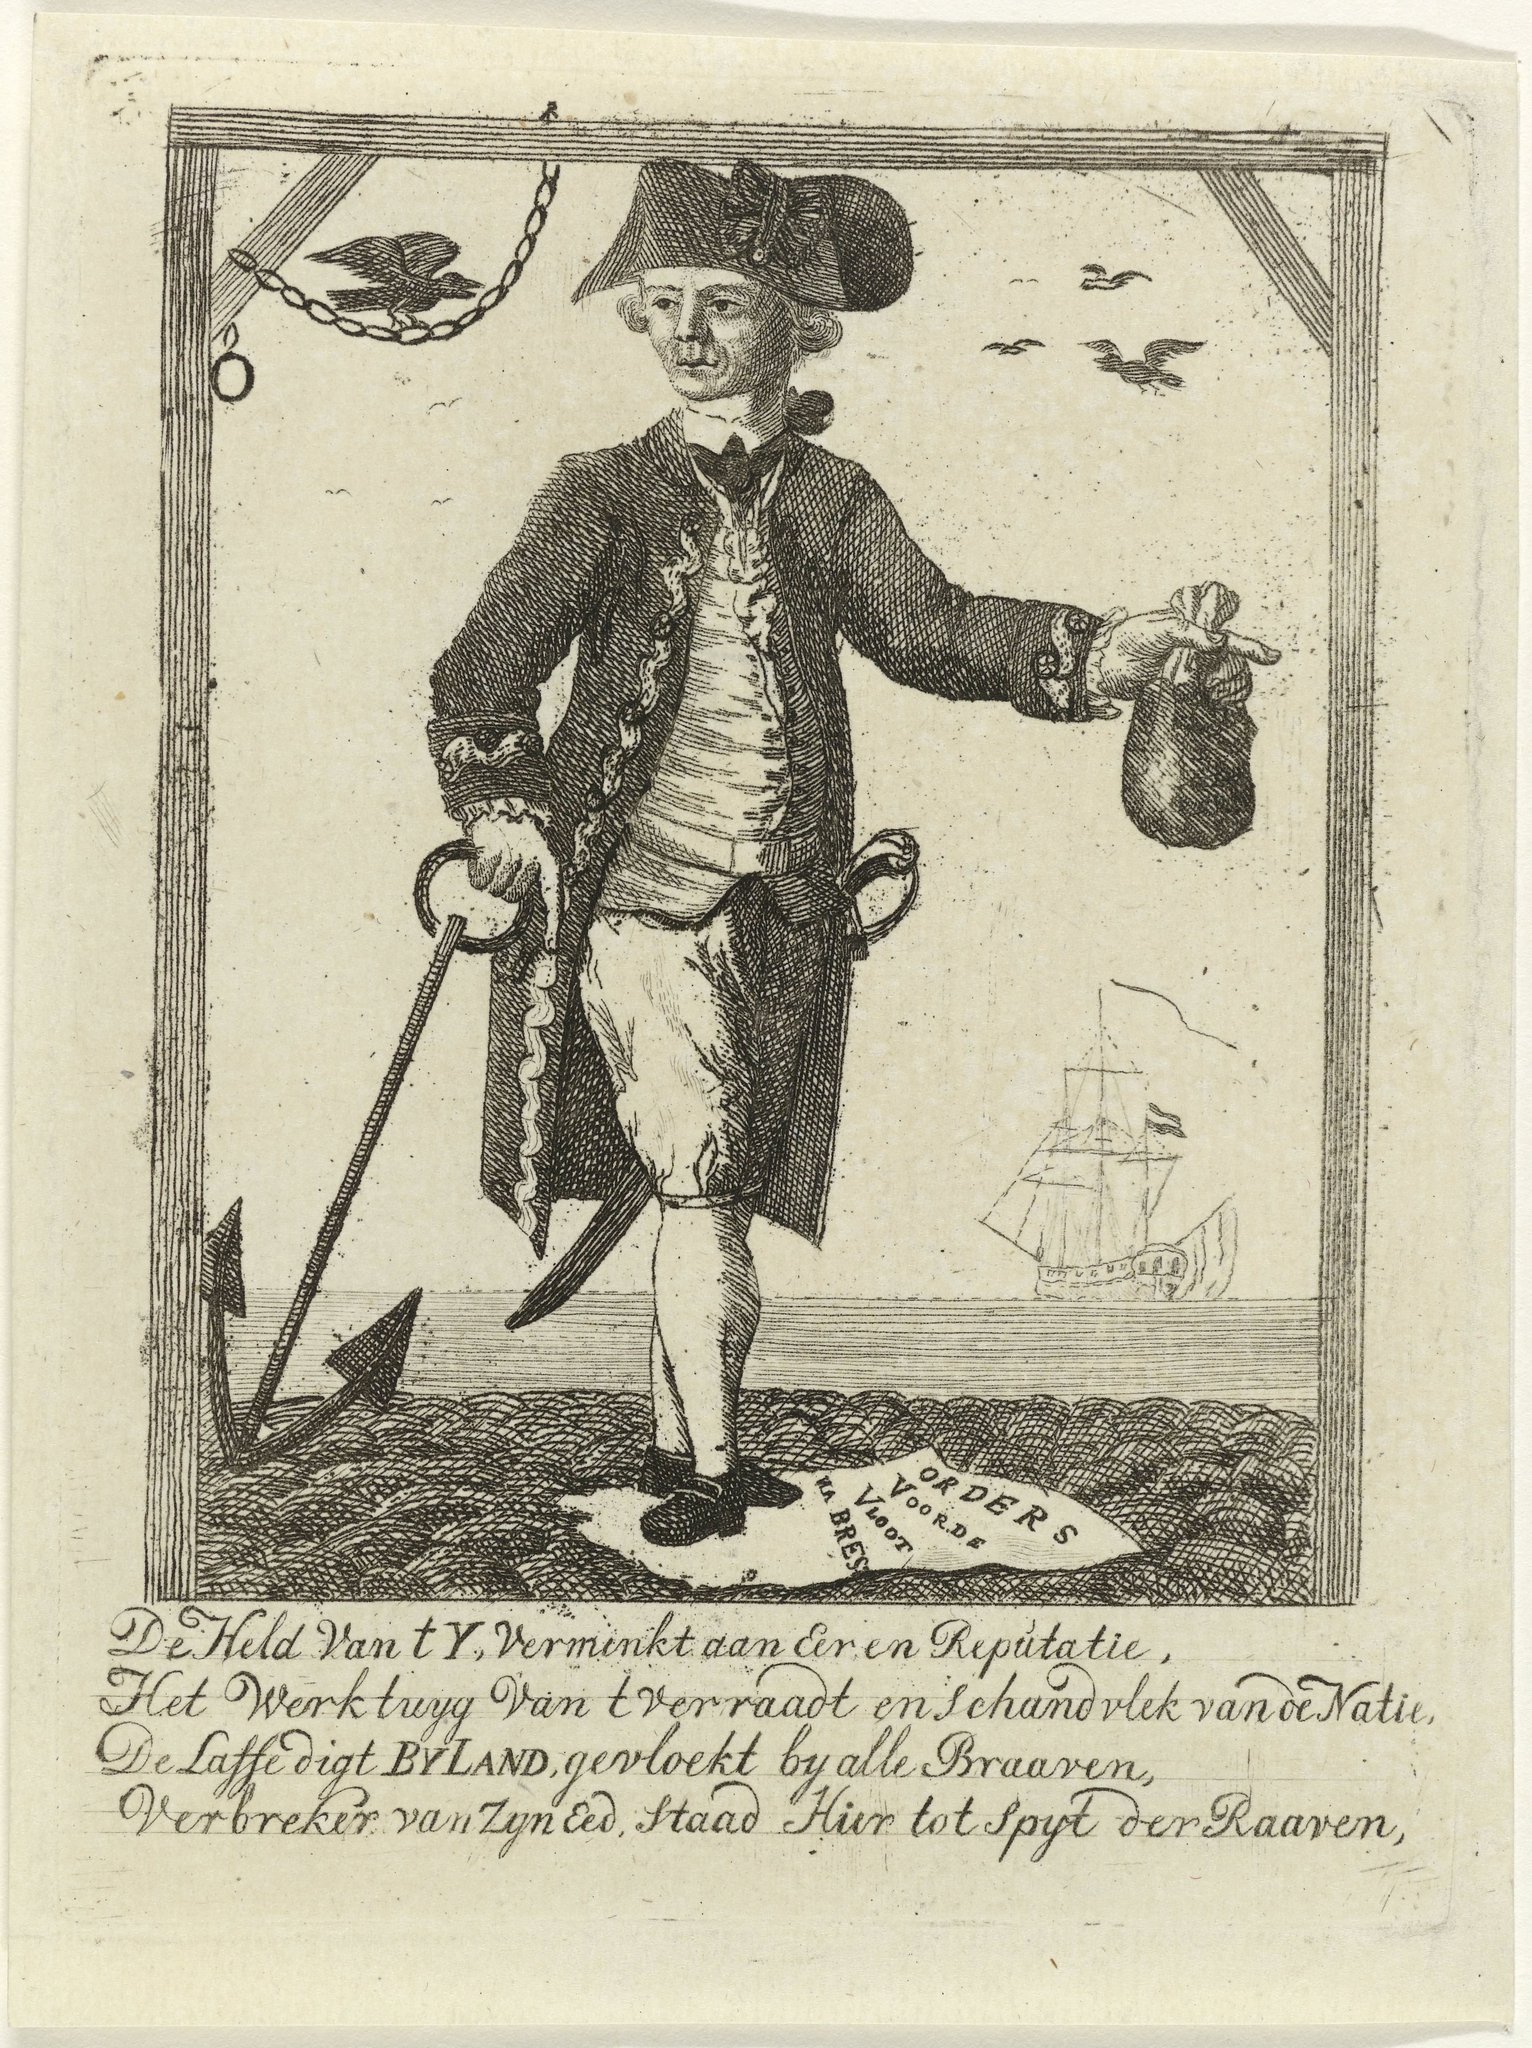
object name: print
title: Spotprent op admiraal van Bylandt, 1782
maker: Anonymous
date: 1782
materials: paper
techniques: engraving, etching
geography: northern netherlands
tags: political caricatures and satires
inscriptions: collector's mark: Lugt 2228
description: Spotprent admiraal Lodewijk van Bylandt, 7 oktober 1782. De admiraal staat met geldzak in de hand terwijl hij het order om de vloot naar Brest te varen vertreedt. Binnen een kader van galgen met linksboven een kraai. Naar aanleiding van het heersend gevoel dat de admiraal zich om had laten kopen om deze orders niet op te volgen. In het onderschrift een vierregelig vers over het vermeende verraad van de admiraal.